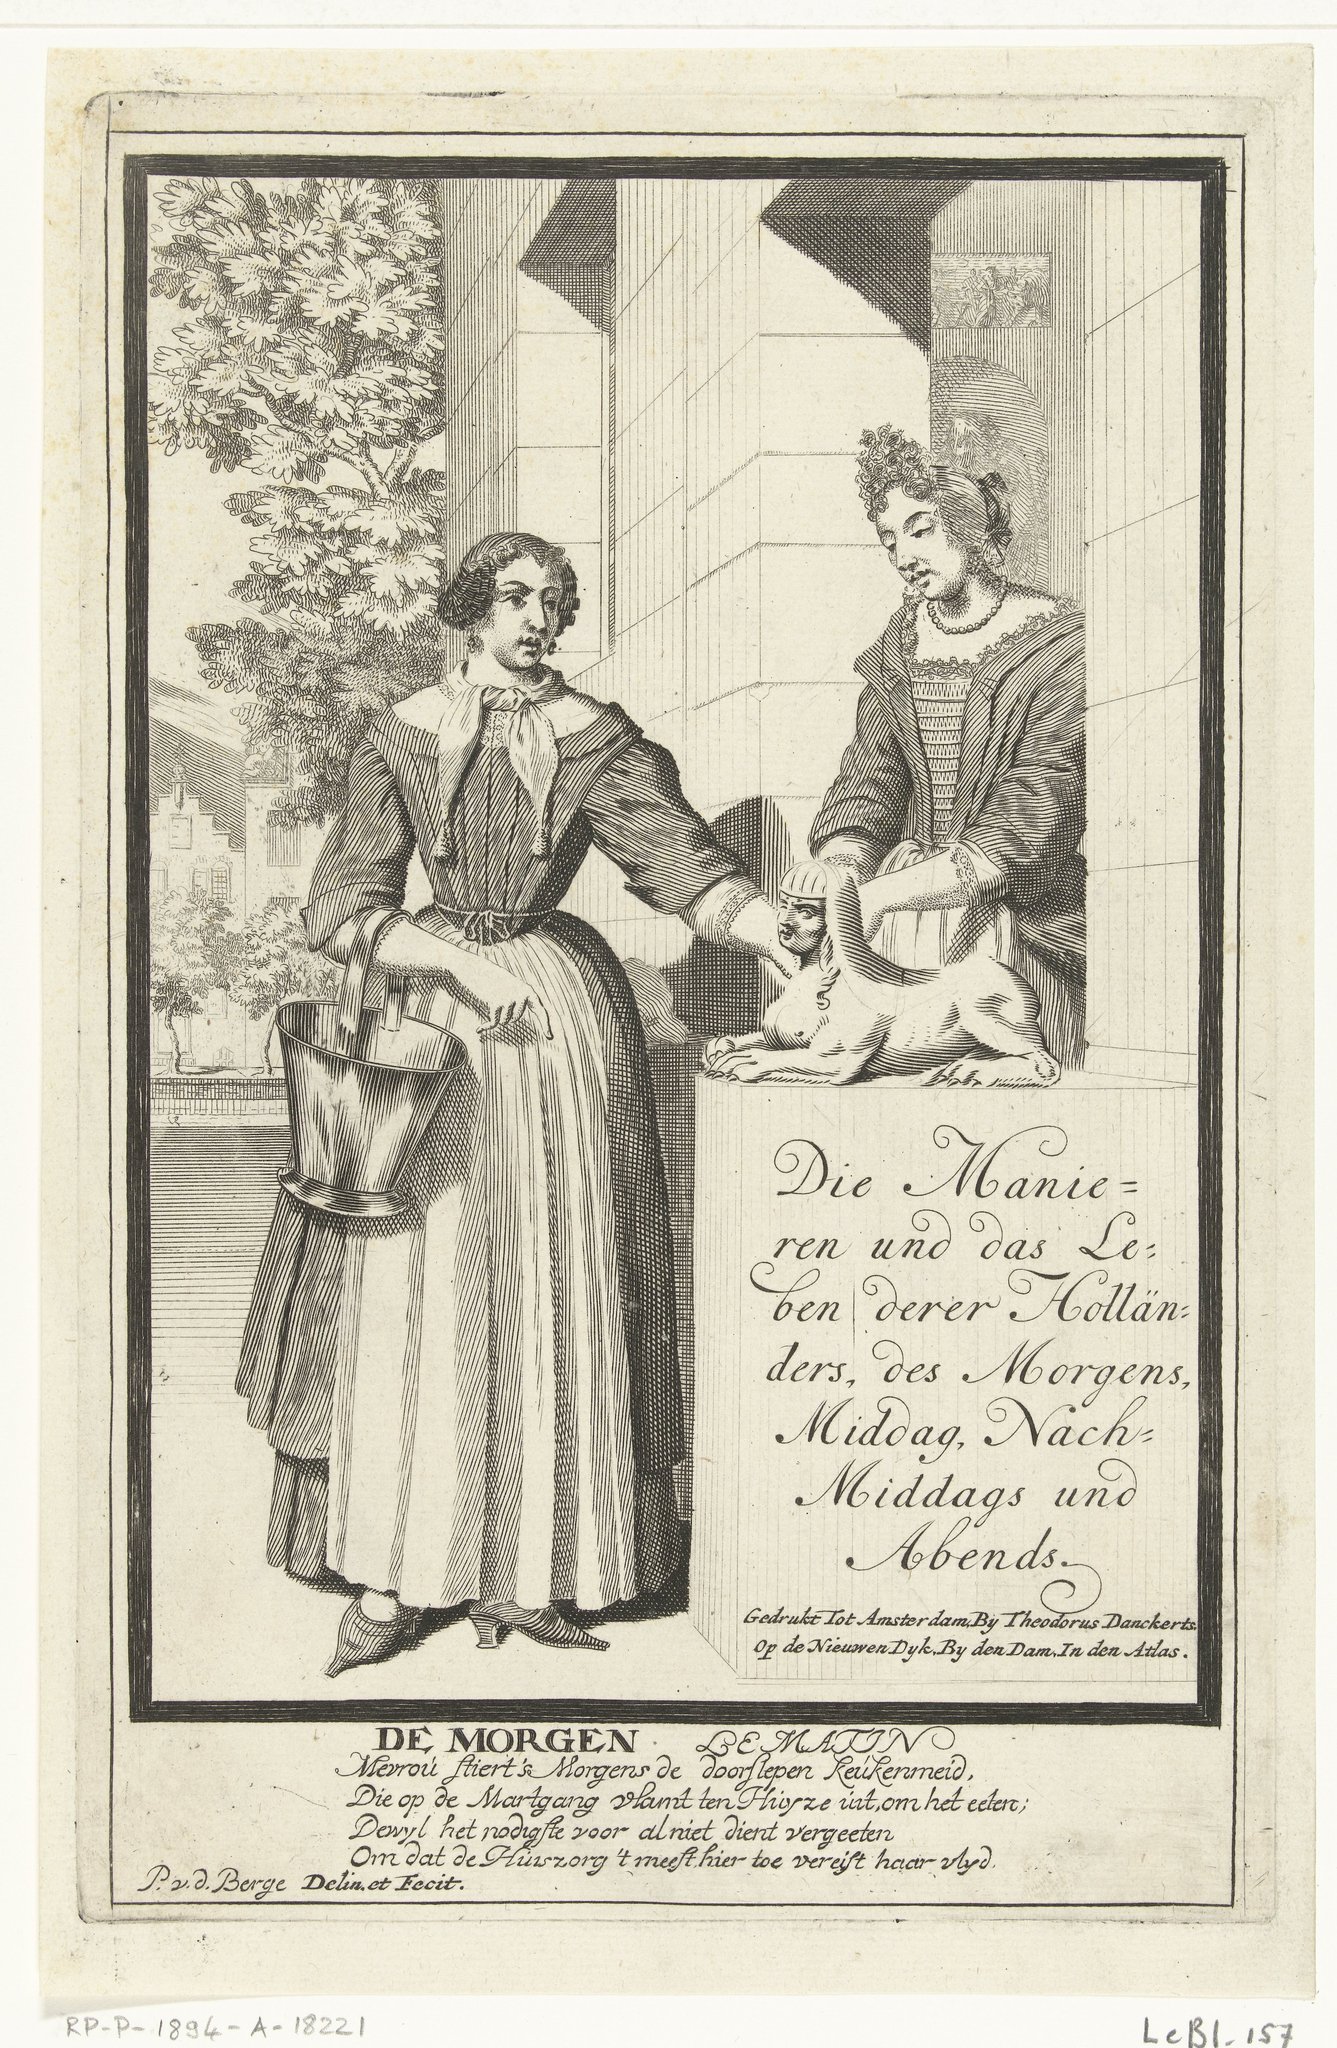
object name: titelprent, frontispice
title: De vier tijden van de dag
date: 1702-1726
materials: paper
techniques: engraving, etching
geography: amsterdam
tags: morning, housewife giving orders to servants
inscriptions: collector's mark: Lugt 2228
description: Titelprent voor de serie: de vier tijden van de dag. Een dame staat in de deuropening van haar huis, op een bordes met beeld van een sfinx. Voor haar staat een keukenmeid met een emmer aan de arm, die naar de markt wordt gestuurd. Onder de prent een vers van vier regels in het Nederlands.